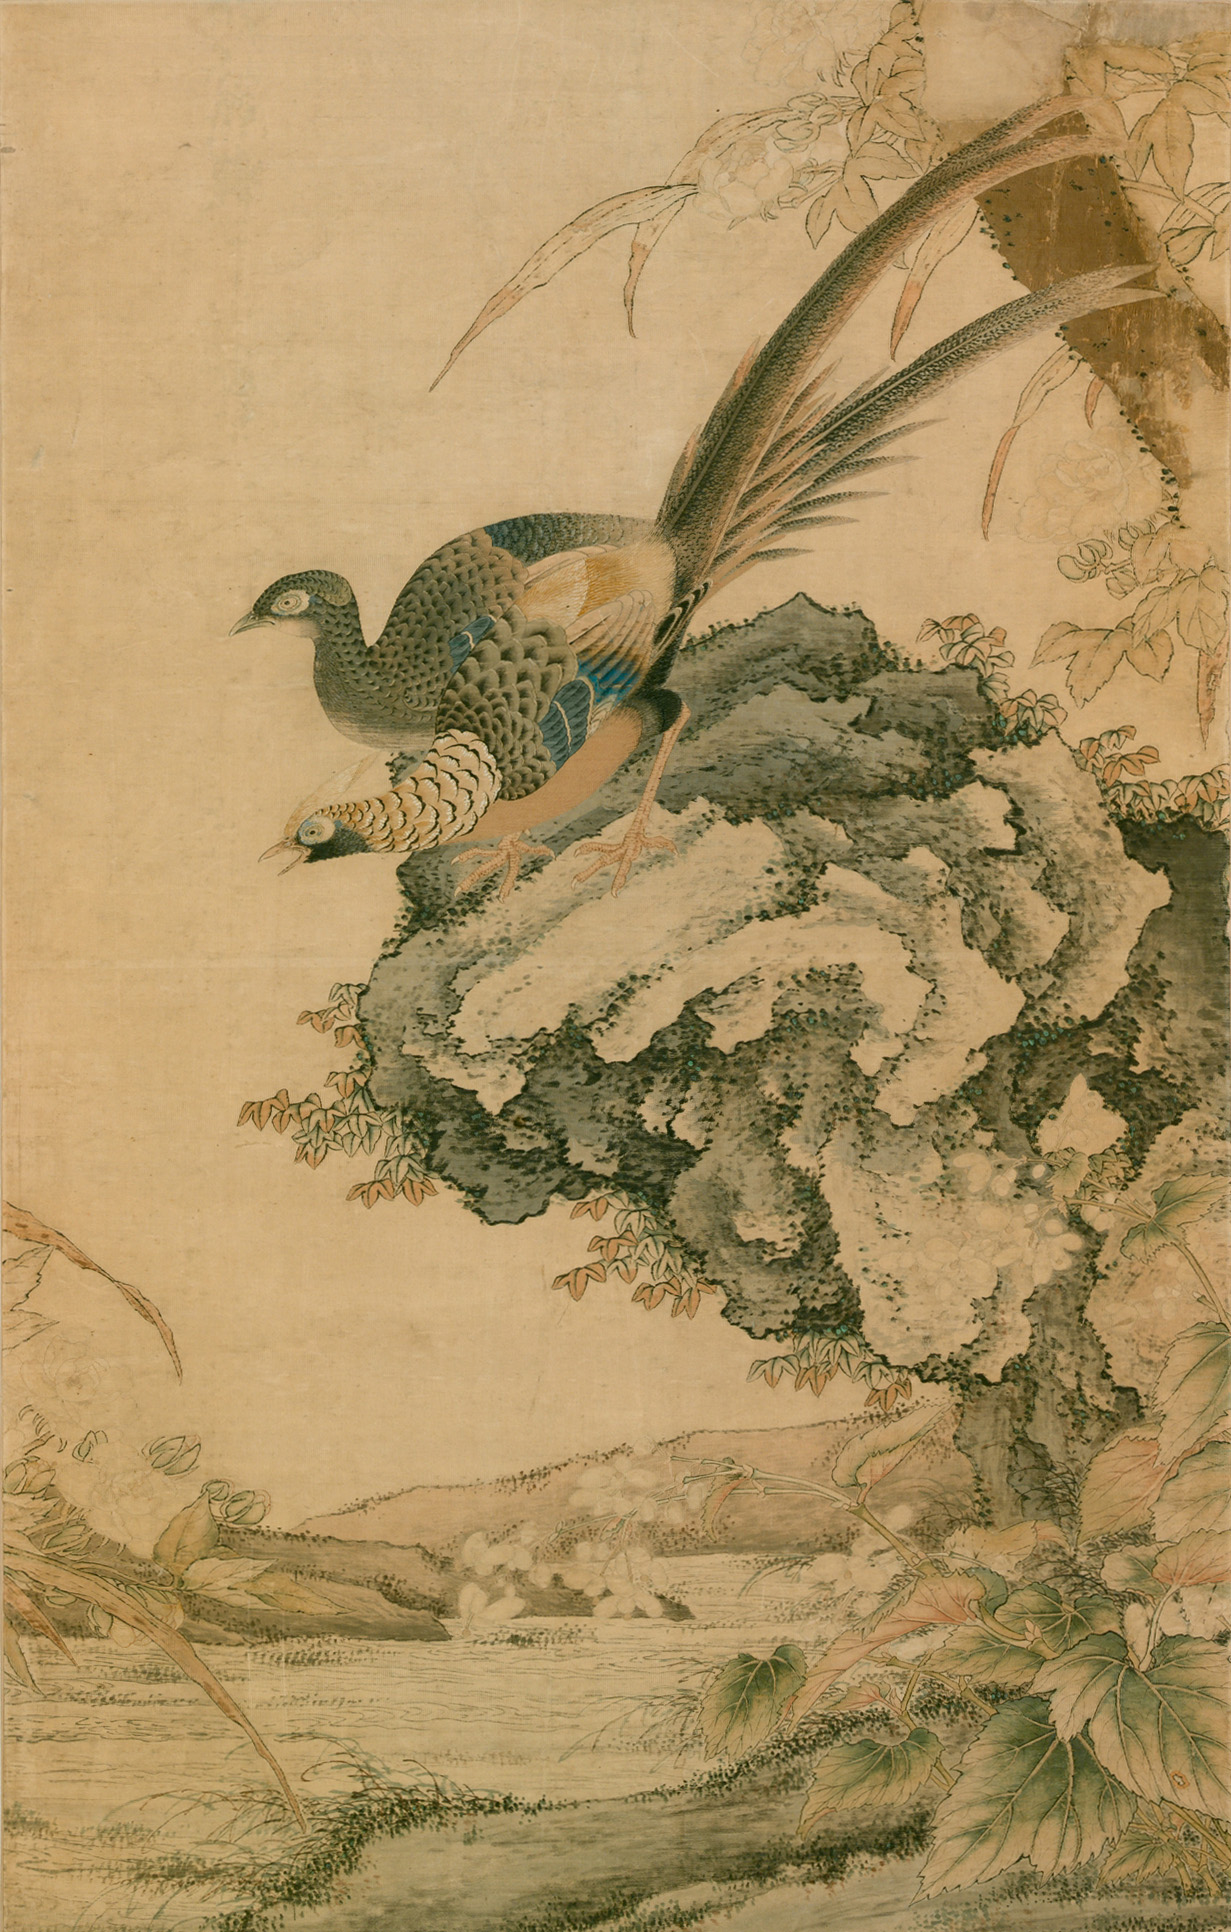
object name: panel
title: Two Pheasants on a Rock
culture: chinese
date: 1801-1900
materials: ink, metal thread, silk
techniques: tapestry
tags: pheasants